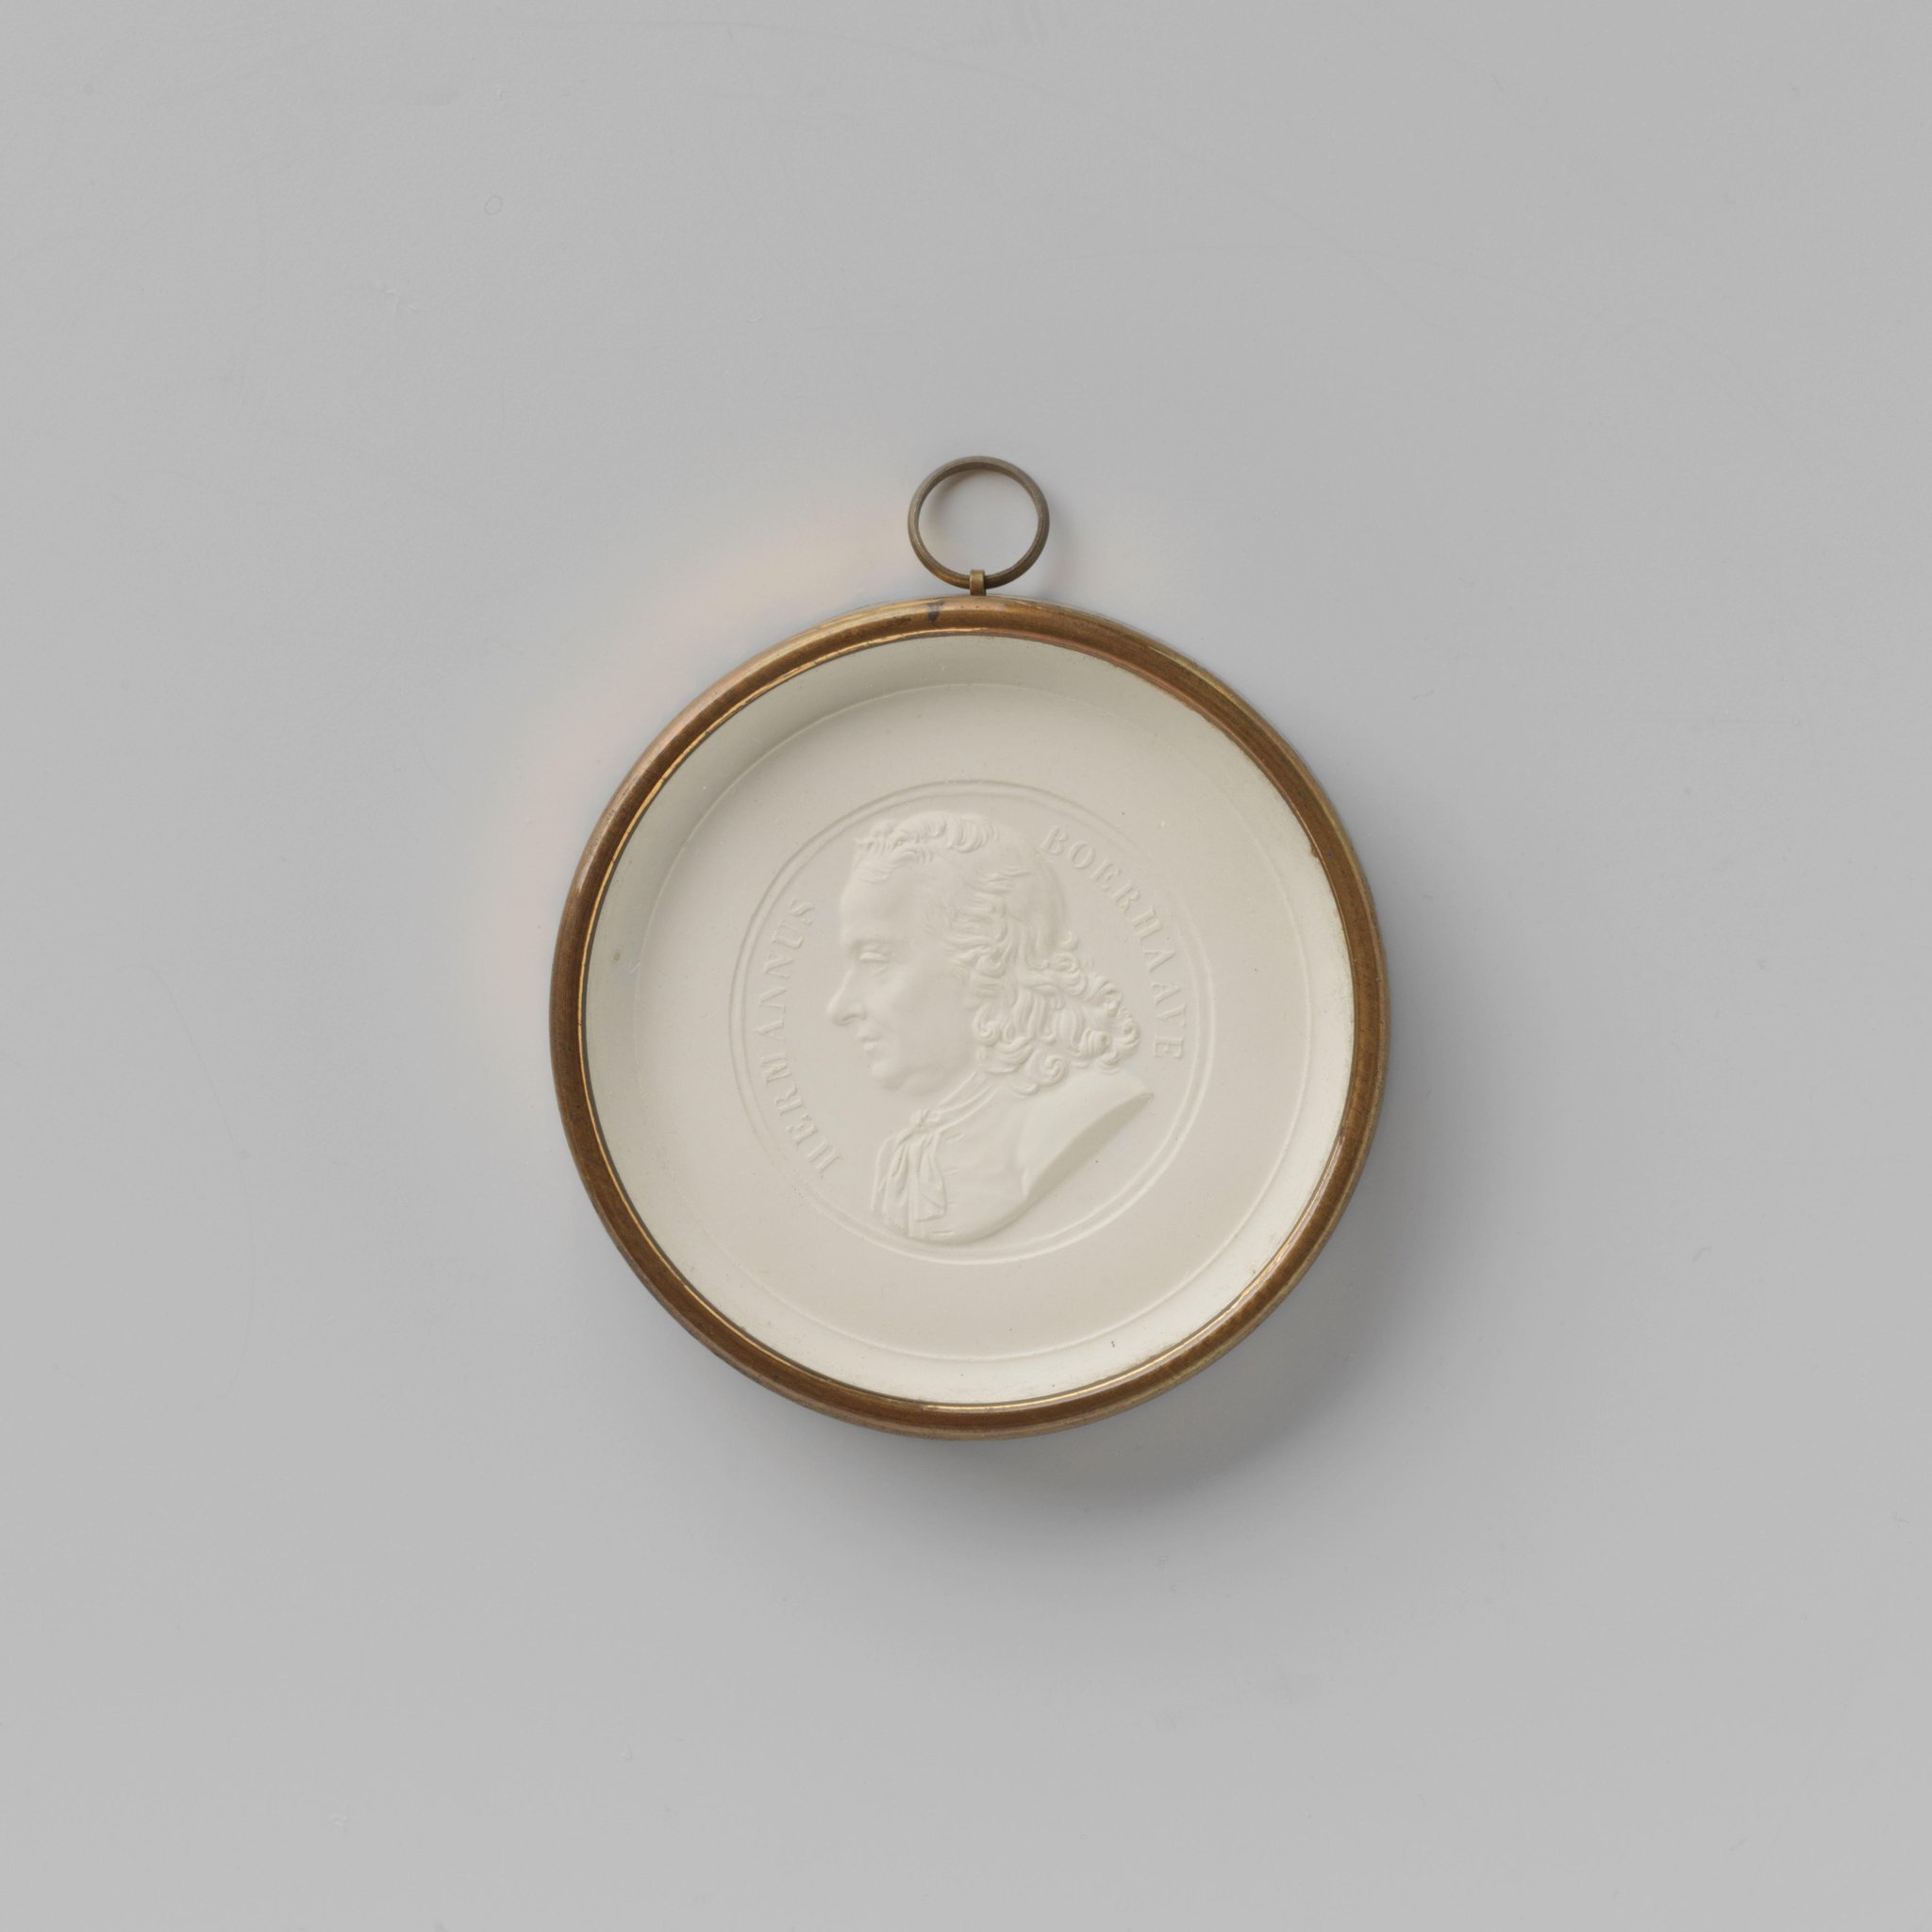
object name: locket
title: Hermanus Boerhaave, geleerde te Leiden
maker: gottfried eichler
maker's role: draughtsman, painter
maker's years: 1677-1757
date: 1687-1757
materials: brass, glass, gypsum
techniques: casting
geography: berlin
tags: leiden, hermanus boerhaave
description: Eenzijdig medaillon in messing ring achter glas aan draagoog en draagring. Voorzijde: borststuk man naar links binnen omschrift. Keerzijde: etiket met opschrift.